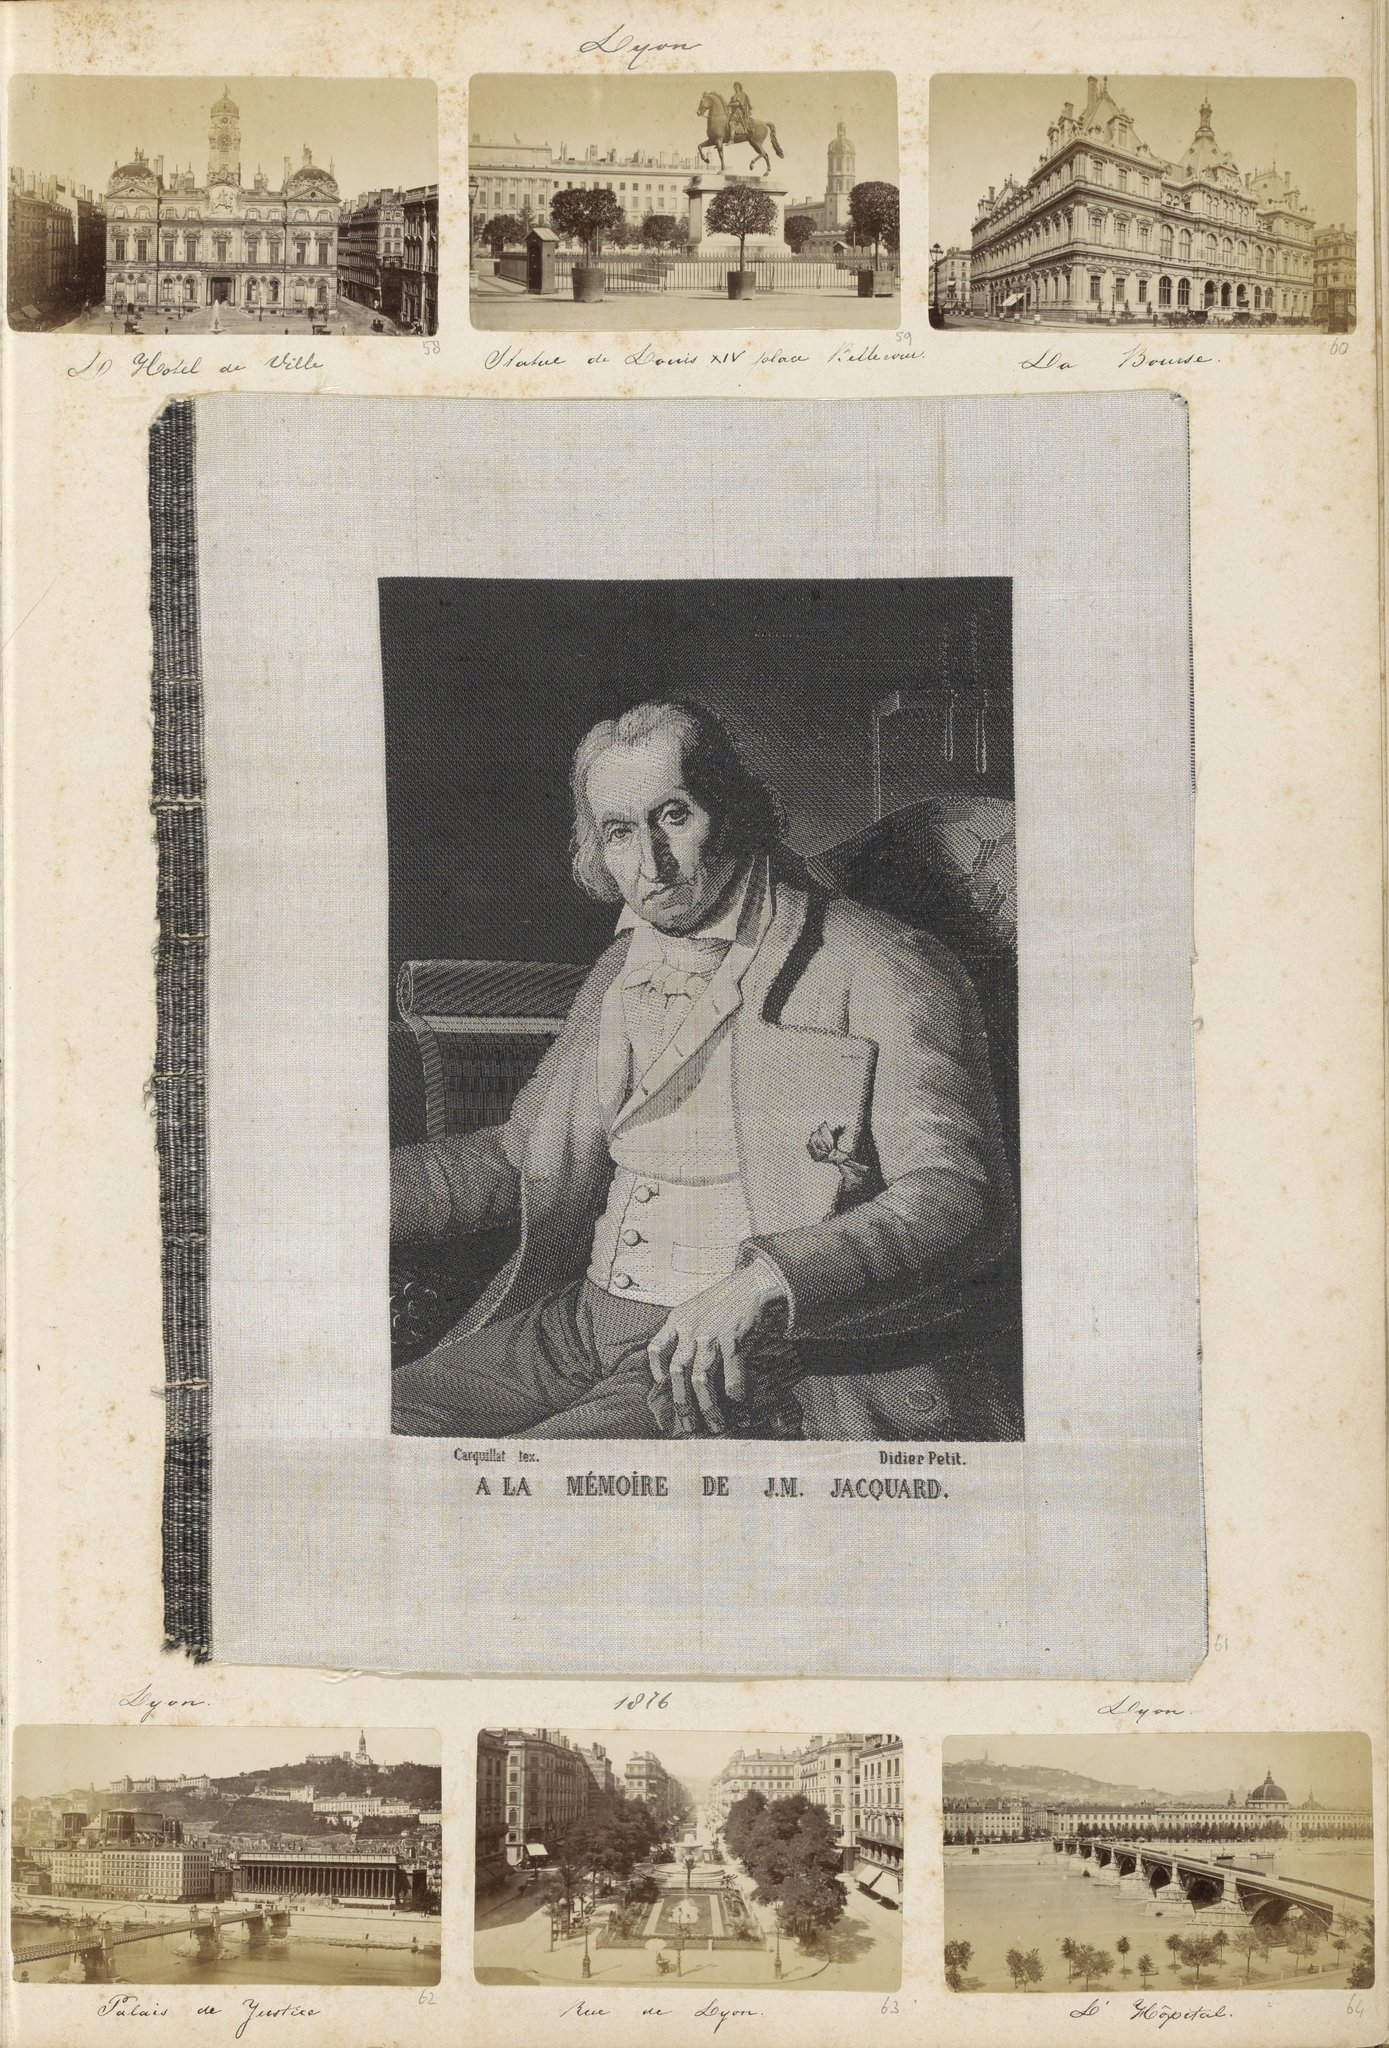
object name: album leaf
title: Gezicht op L'Hôpital in Lyon met op de voorgrond de Pont de Guillotière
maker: Anonymous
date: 1876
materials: paper, photographic support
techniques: albumen print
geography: lyon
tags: hospital, bridge in city across river, canal, etc., lyon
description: Onderdeel van Fotoalbum van Robert Daniel Crommelin (1841-1907).